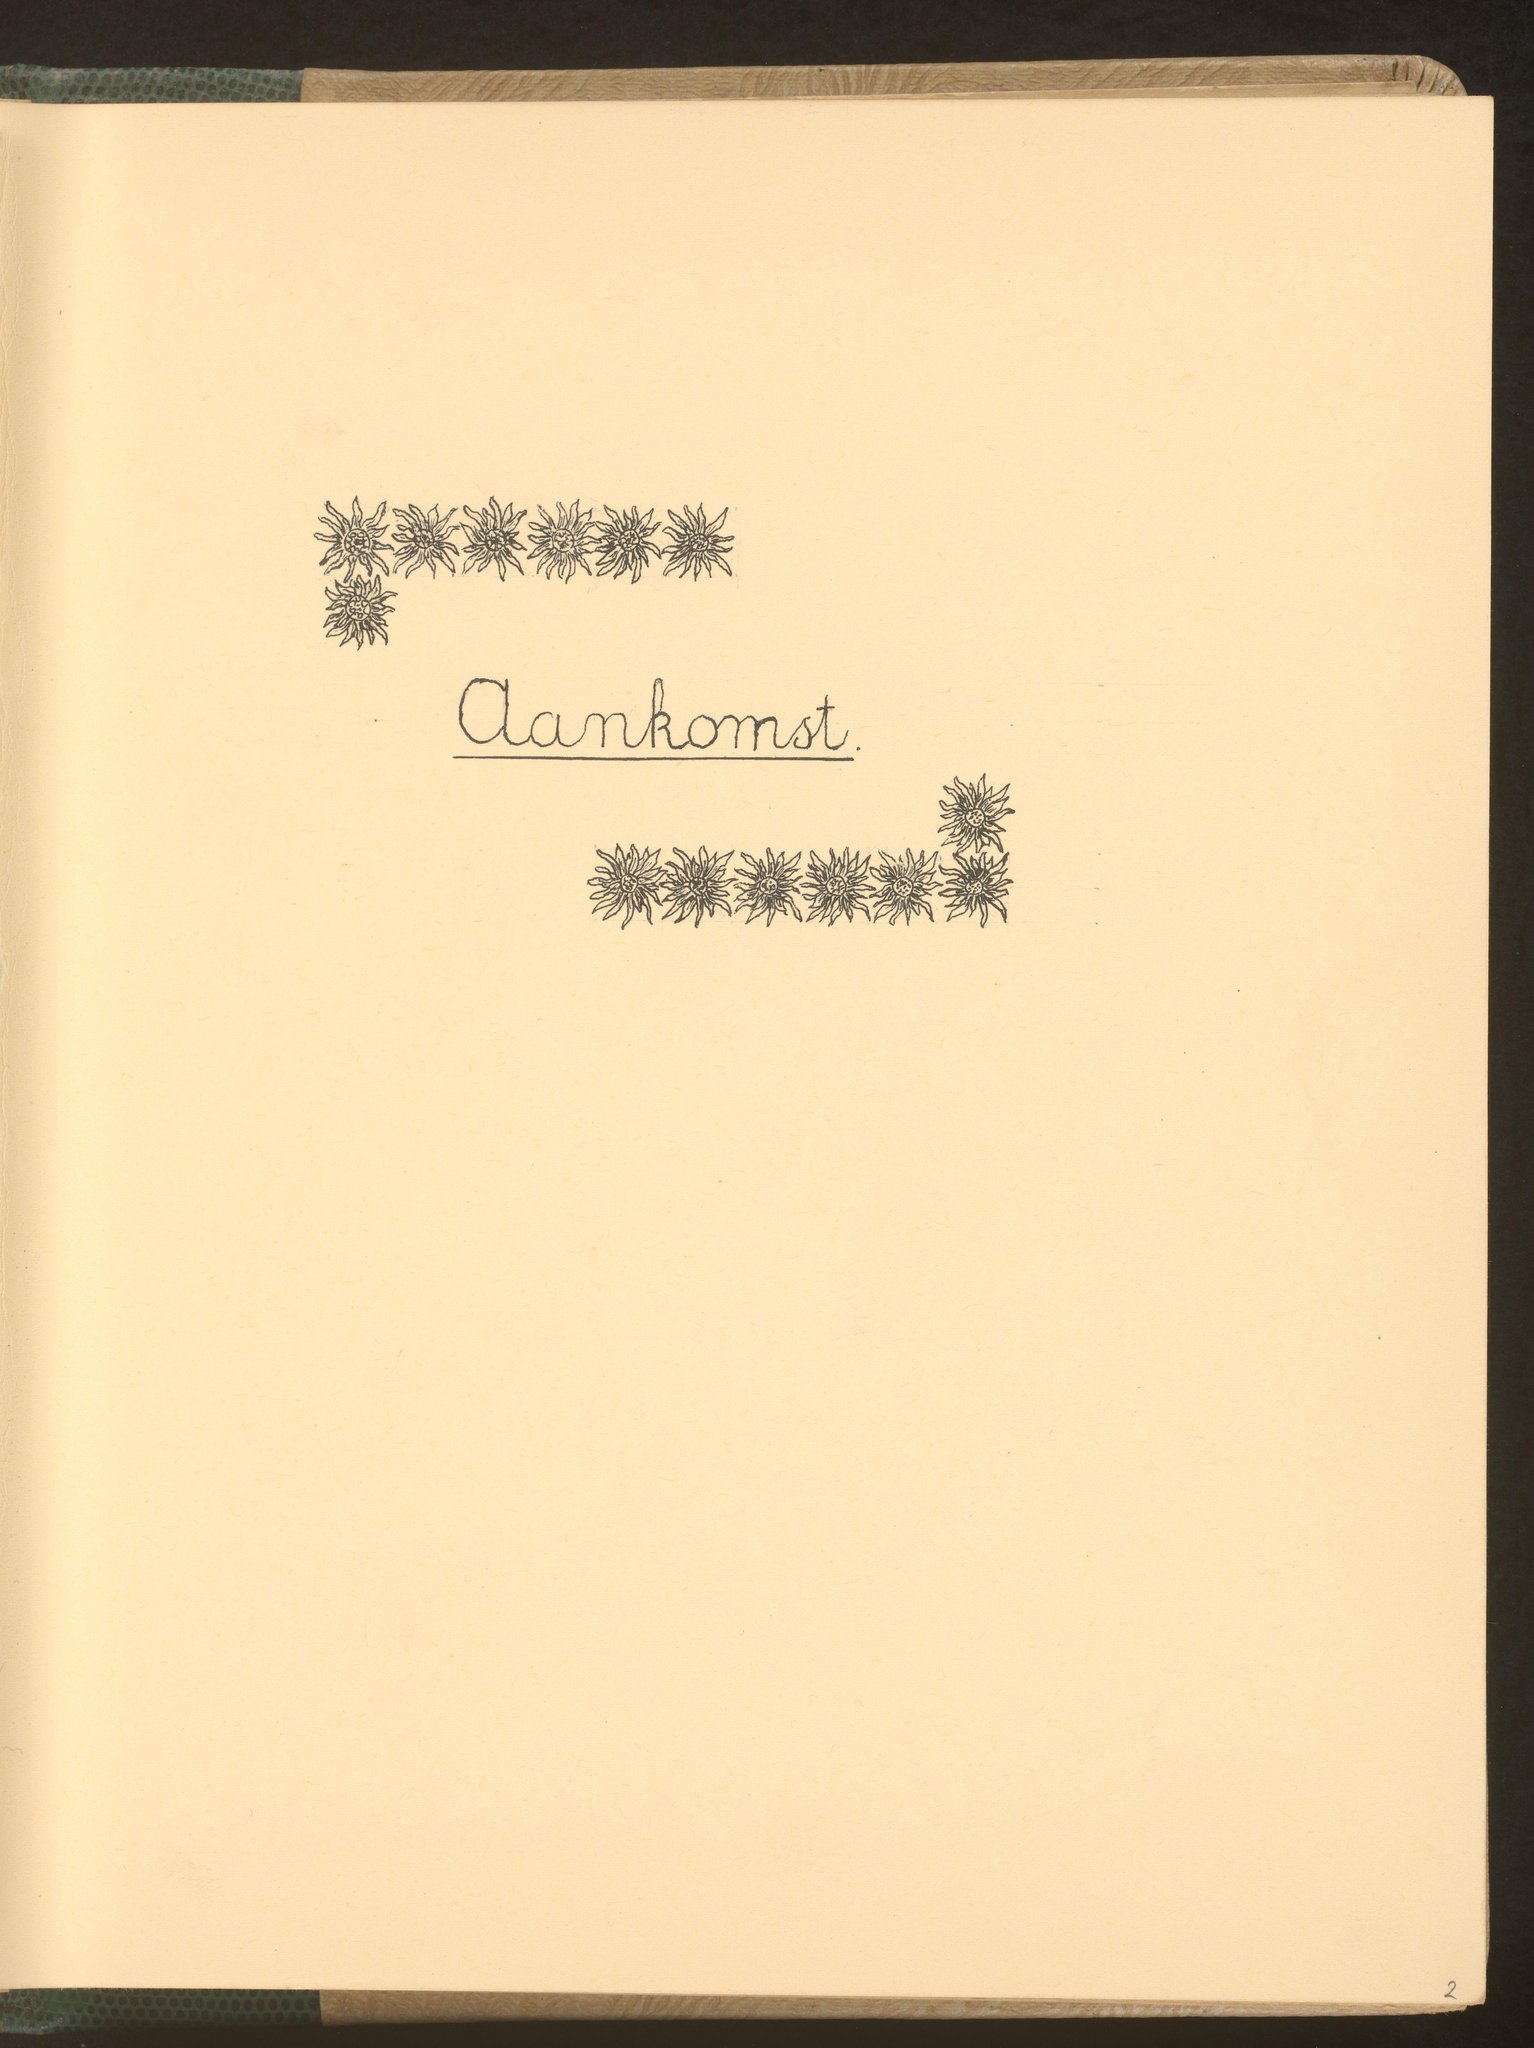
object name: manuscript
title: Aankomst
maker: Anonymous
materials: ink, paper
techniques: handwriting, pen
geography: lochem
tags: the hague, willem drees, old-people's home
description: Handgeschreven titel voor de foto op het volgende blad. Onderdeel van het fotoalbum over de opening van het bejaardenhuis De Berkelhof in Lochem door premier Willem Drees op 8 augustus 1953.